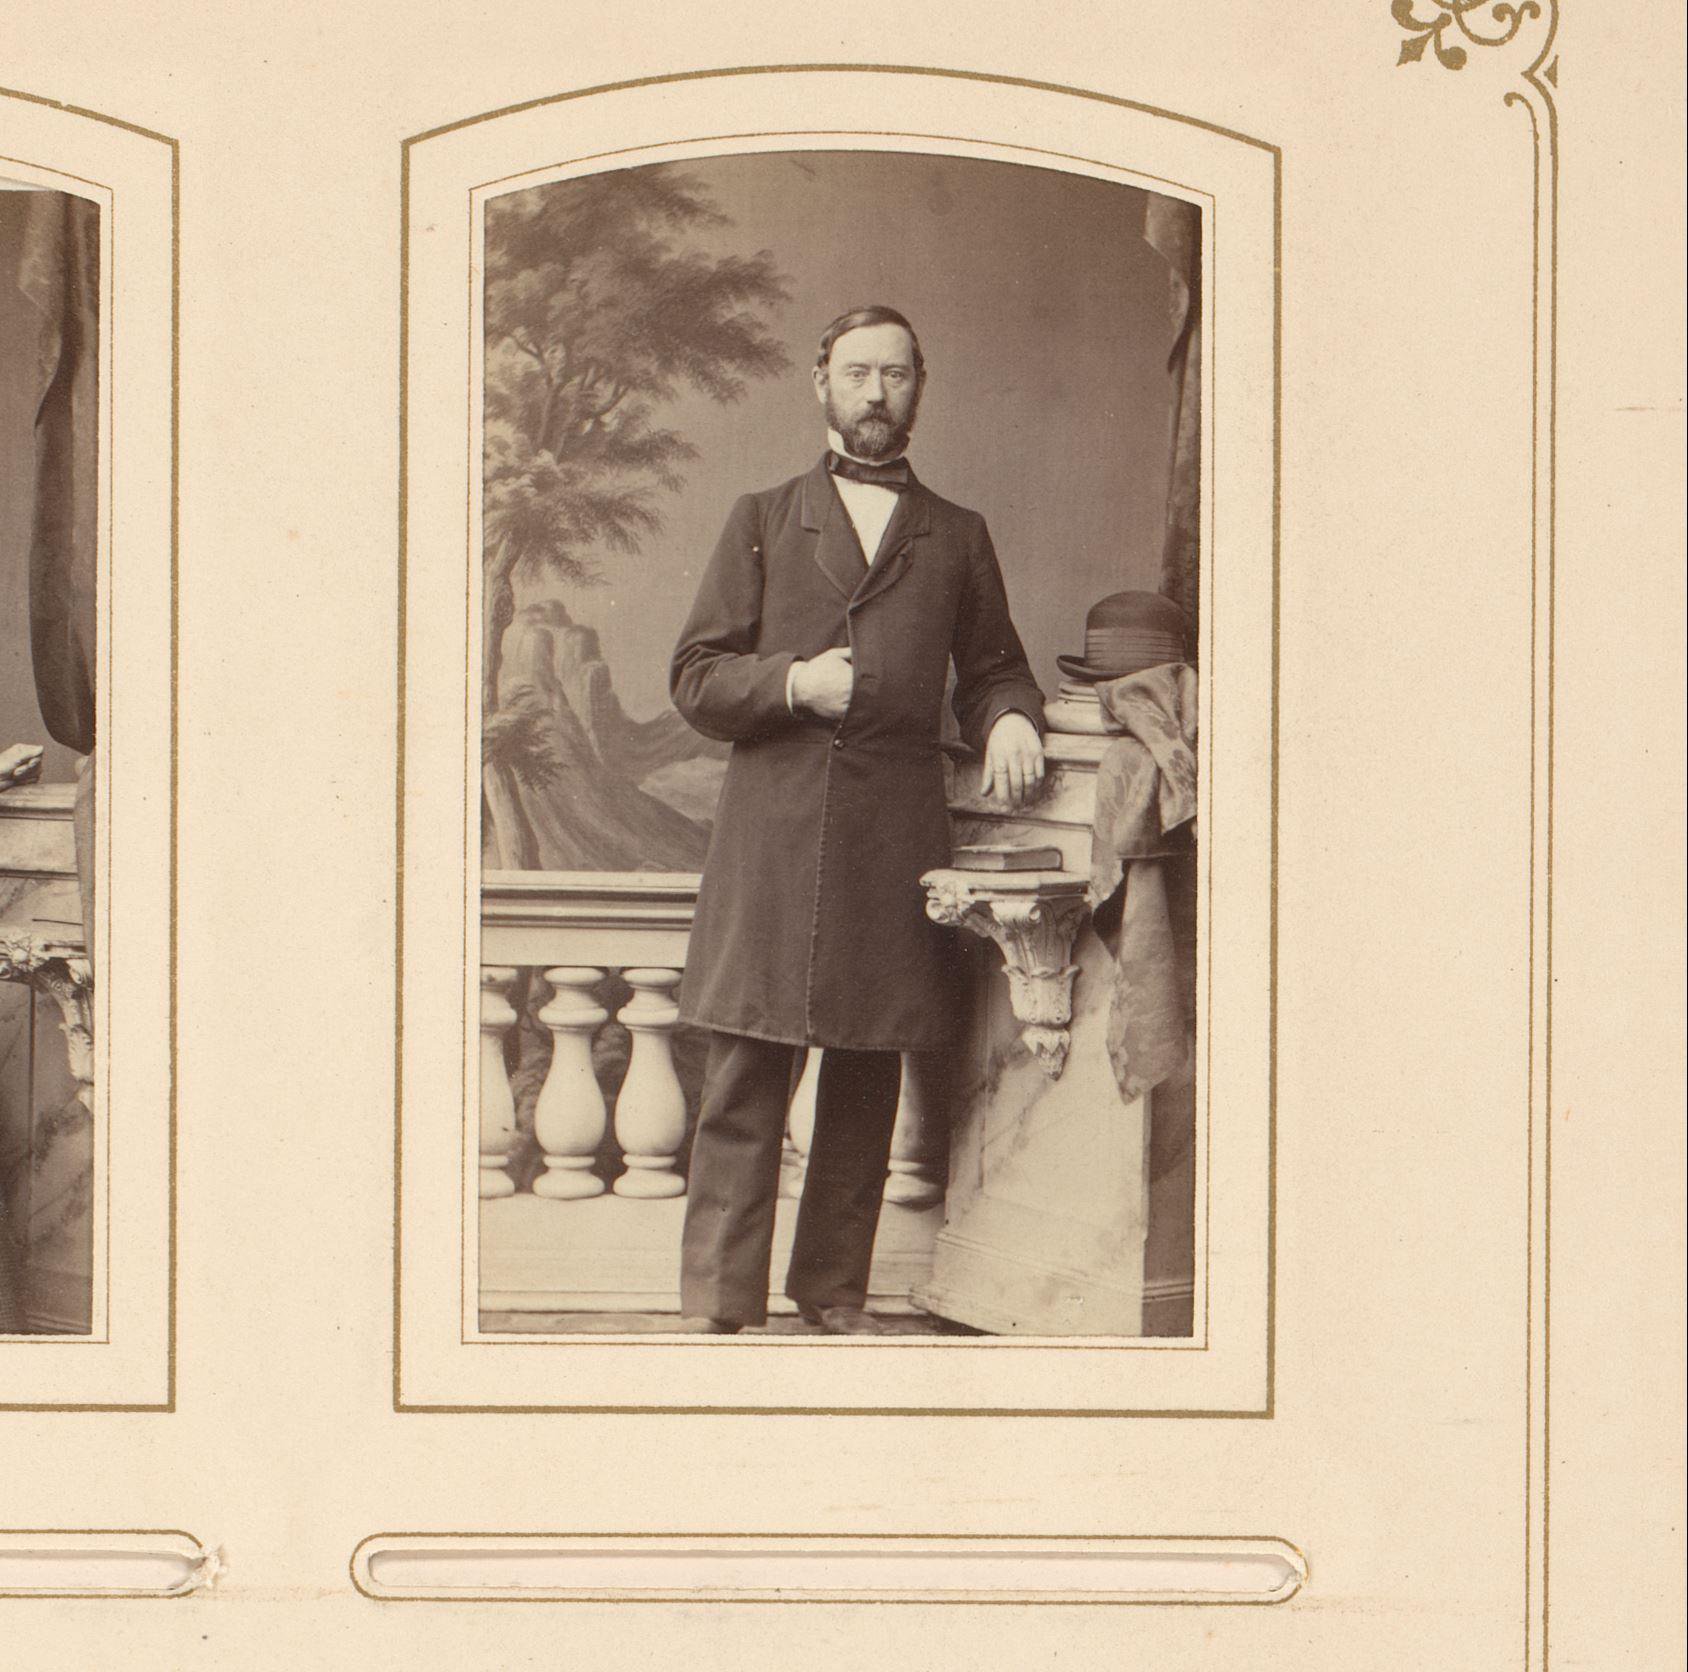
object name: photograph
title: Portret van een man met een hand in zijn jas gestoken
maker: Anonymous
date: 1850-1900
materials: cardboard, photographic support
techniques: albumen print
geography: germany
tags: coat, historical persons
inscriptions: annotation: ‘Karl Sch[ät]ze, onkel’